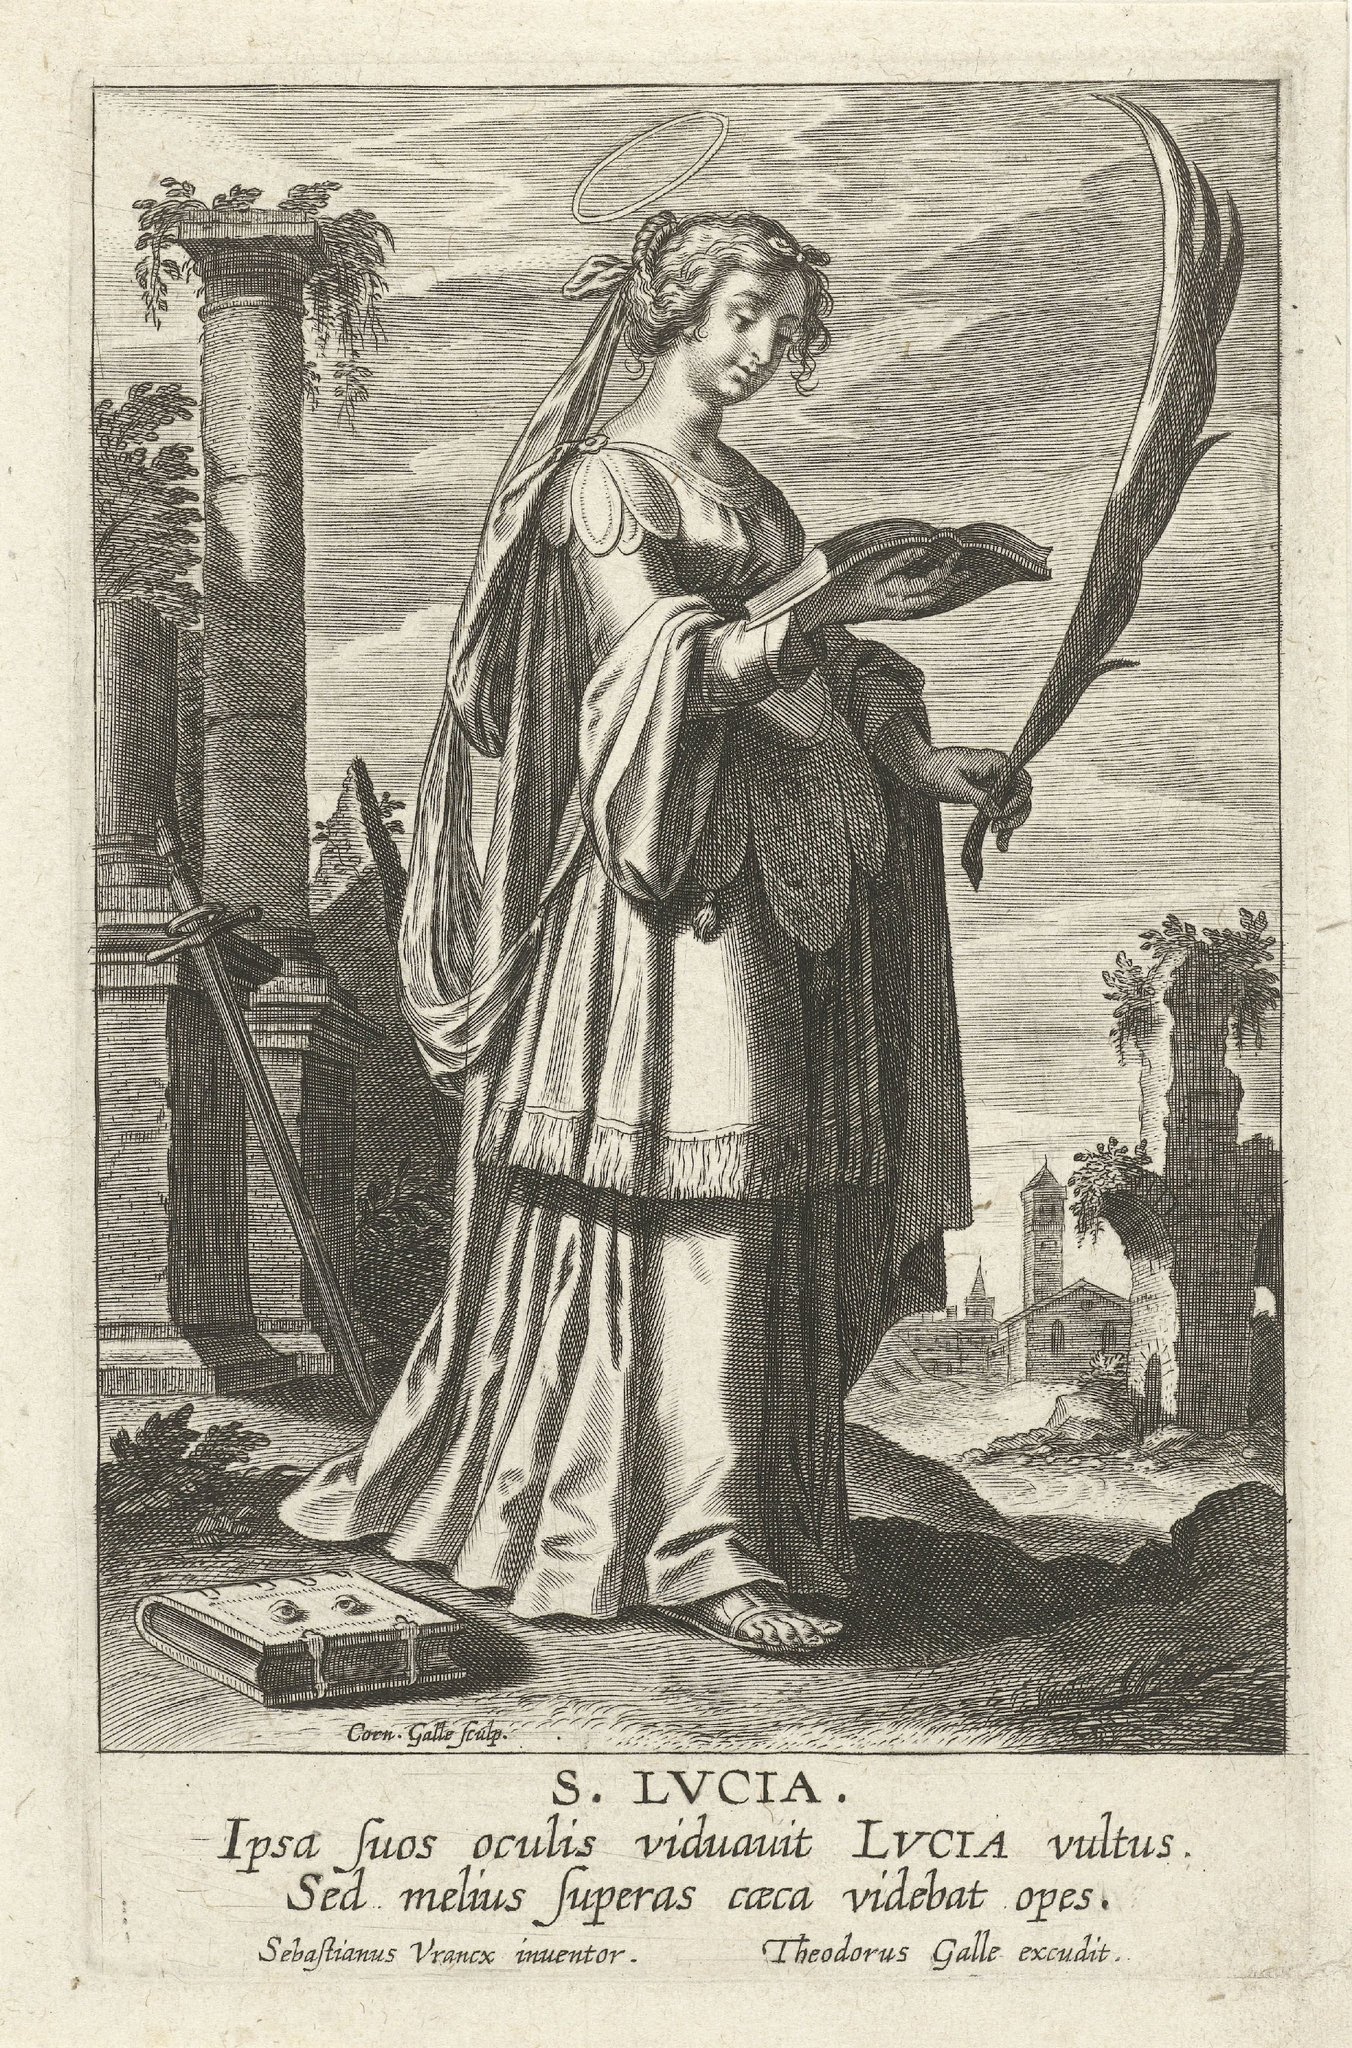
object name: print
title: H. Lucia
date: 1596-1633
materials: paper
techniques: engraving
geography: southern netherlands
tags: the virgin martyr lucy (lucia) of syracuse; possible attributes: dagger or sword (in neck), eyes, flames at feet, lamp, ox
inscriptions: collector's mark: Lugt 2228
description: De heilige Lucia staande in een ruïnelandschap. Lucia houdt een palmtak in haar hand en leest in een boek.Onder de voorstelling een Latijns vers op Lucia. Waarschijnlijk deel van een serie van vrouwelijke heiligen uitgegeven door Theodoor Galle.